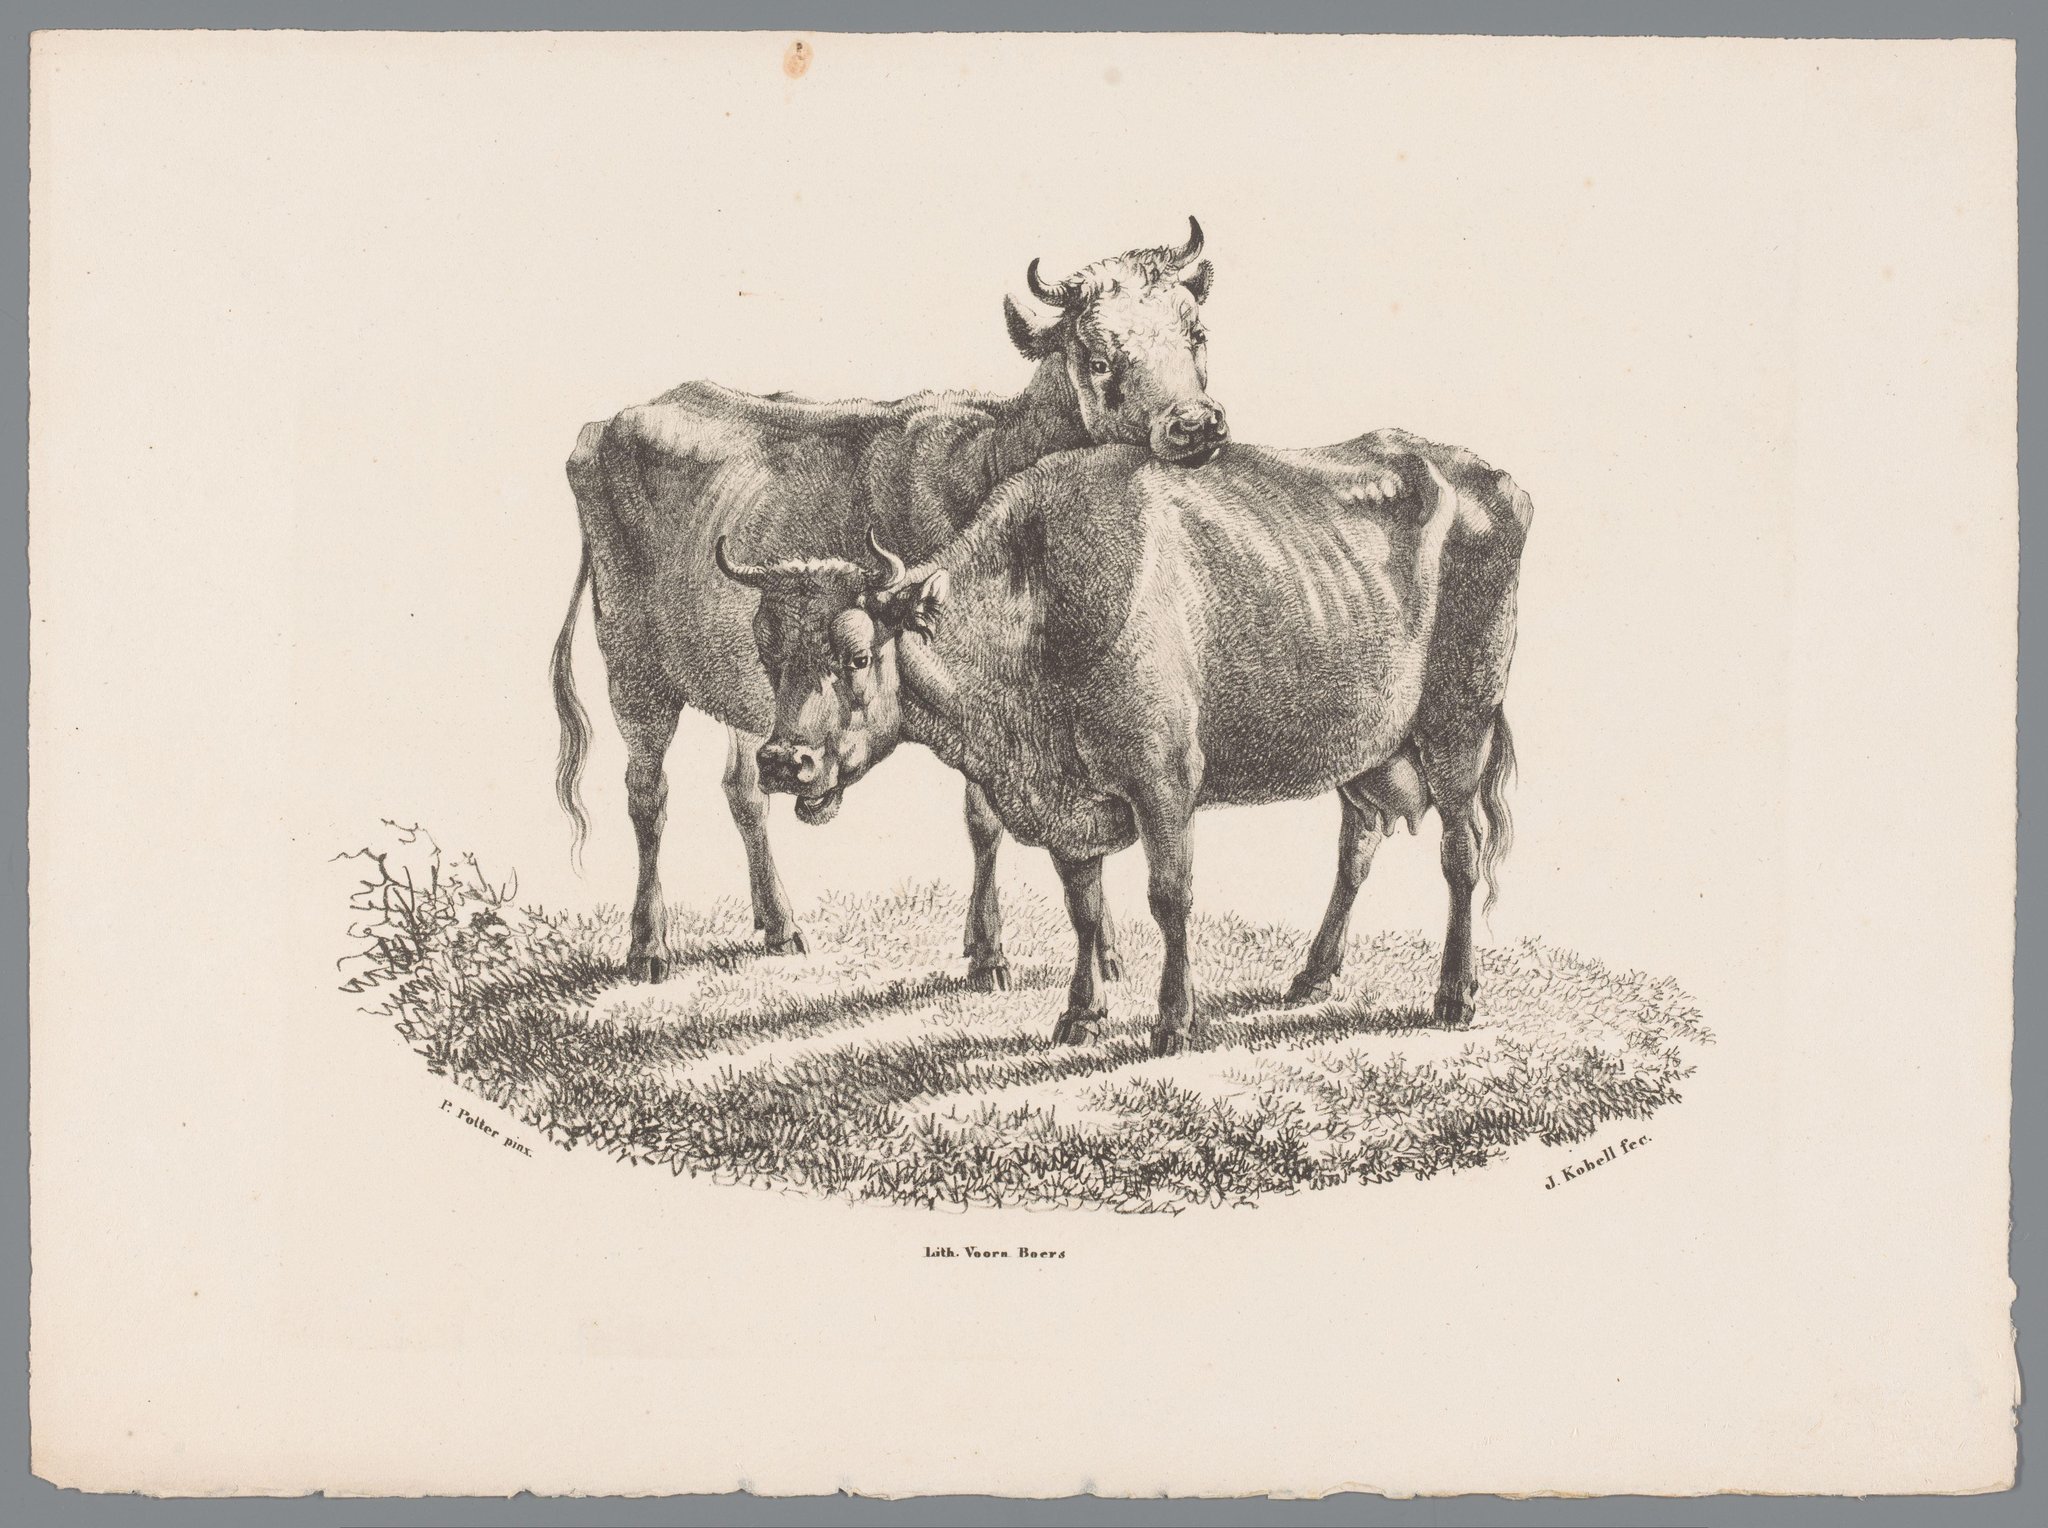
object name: print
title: Beesten Studien door J. Kobell naar Paul Potter Nr. 1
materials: paper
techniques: lithograph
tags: cow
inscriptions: collector's mark: Lugt 2228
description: De koeien staan dicht bij elkaar. Een koe kijkt over de rug van de andere koe. Deze prent maakt deel uit van een omslag met zes losse prenten.